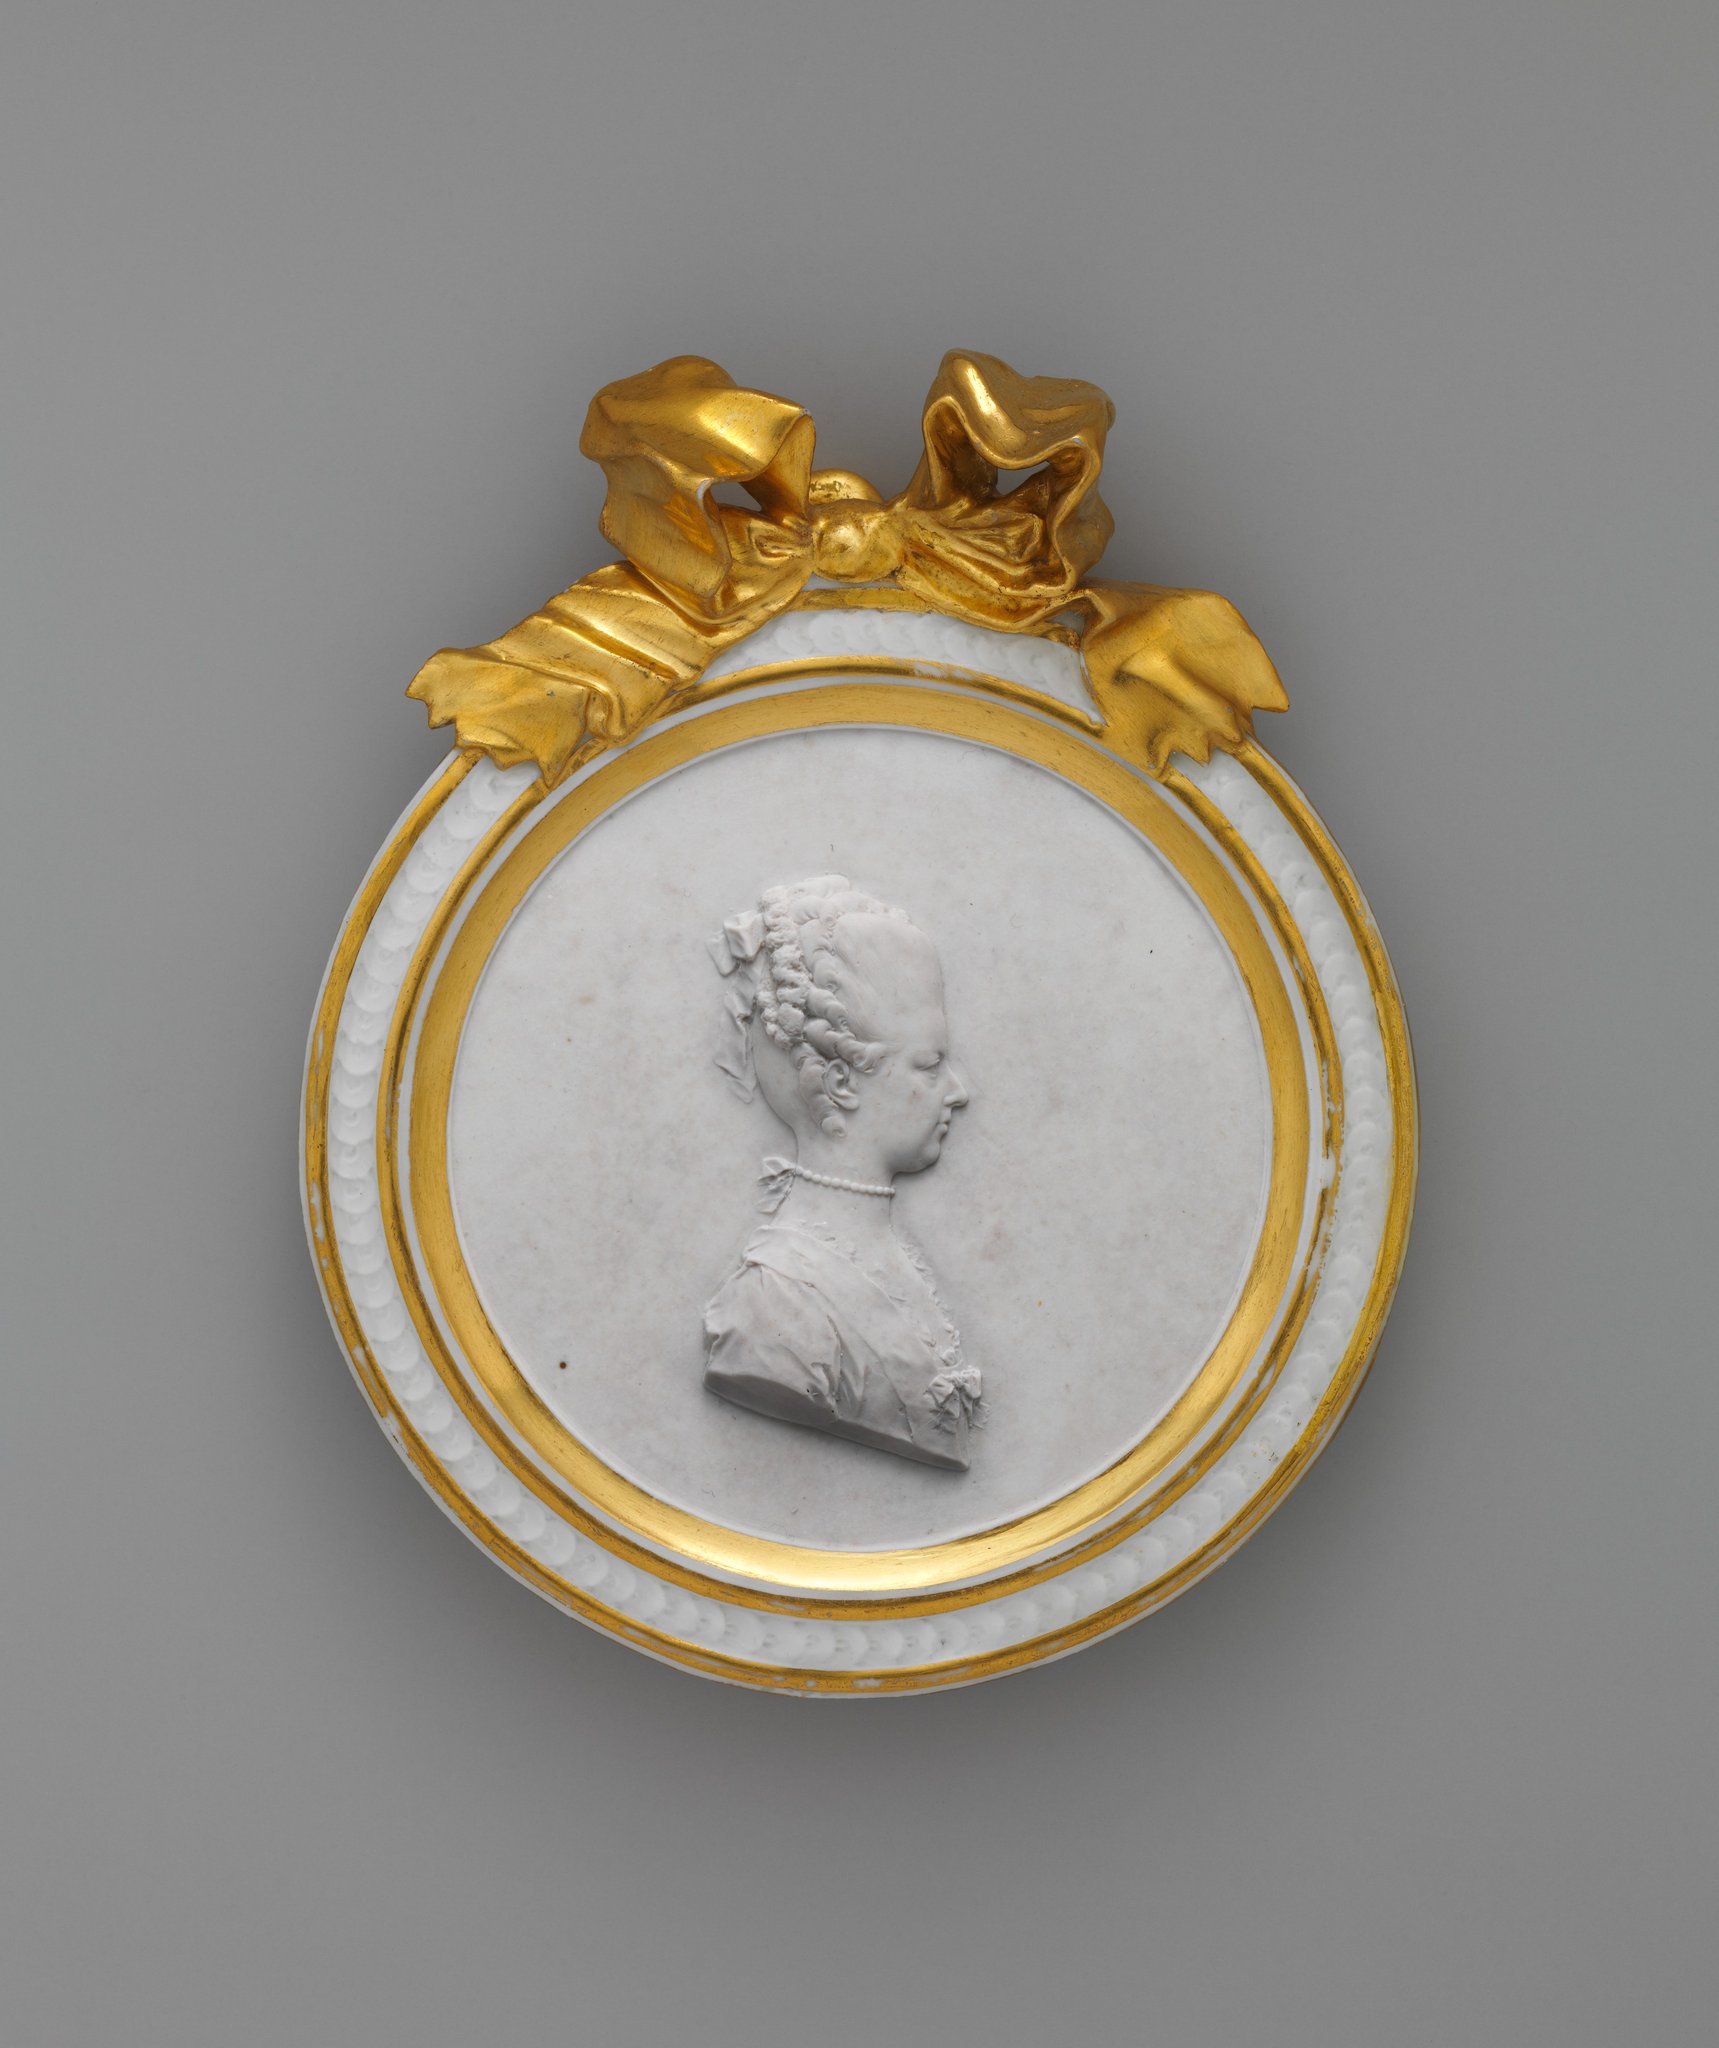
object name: plaque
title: Maria Christine Teschen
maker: imperial porcelain manufactory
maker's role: manufactory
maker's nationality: austrian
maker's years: 1744-1864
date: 1775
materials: hard paste porcelain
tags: profiles,women